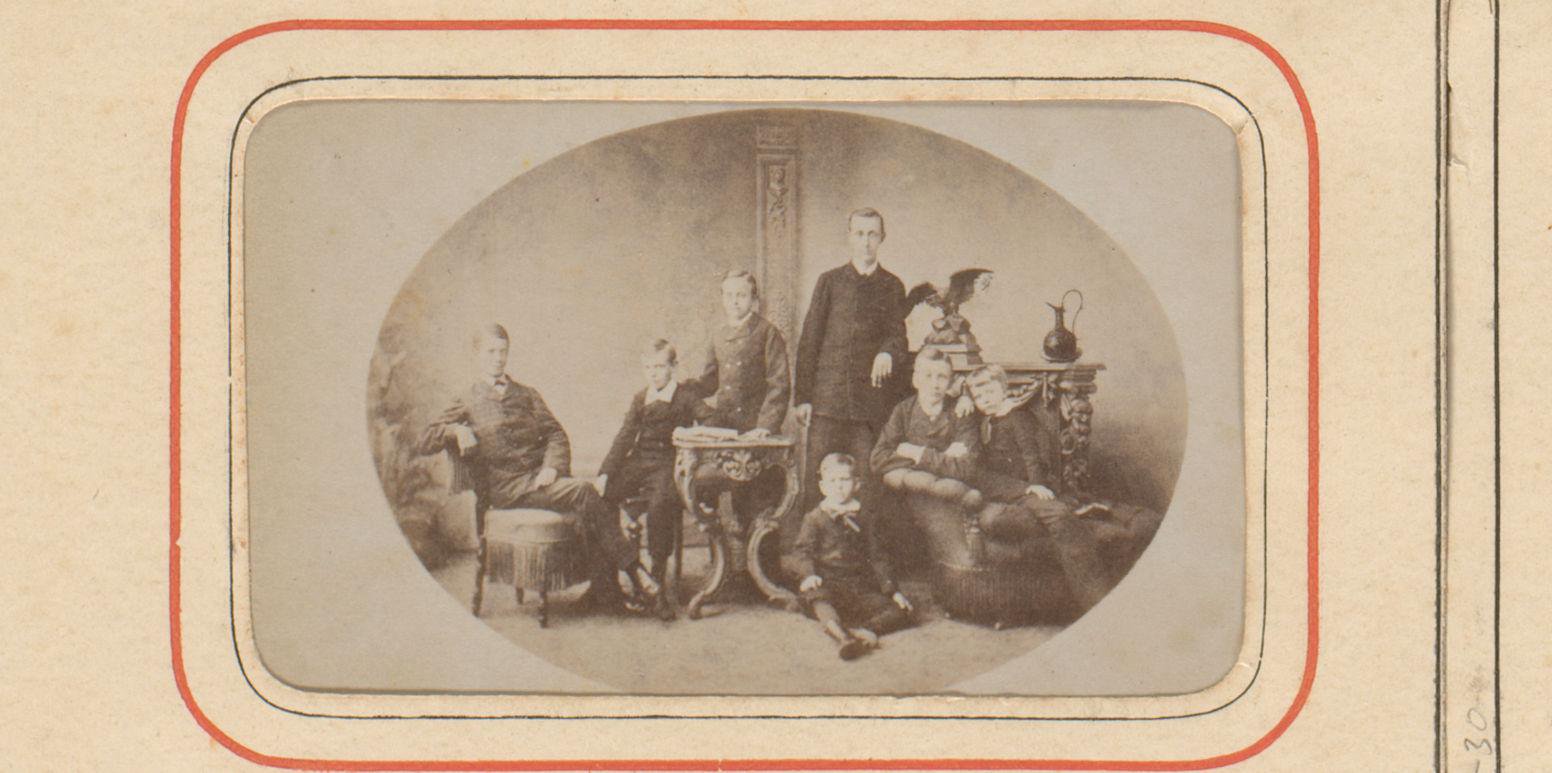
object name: album leaf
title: Groepsportret van zeven onbekende jongens, mogelijk broers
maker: bernardus bruining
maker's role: fotograaf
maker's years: 1834-1900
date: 1880-1890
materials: cardboard, paper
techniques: albumen print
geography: arnhem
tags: anonymous historical persons portrayed in a group, in a group-portrait